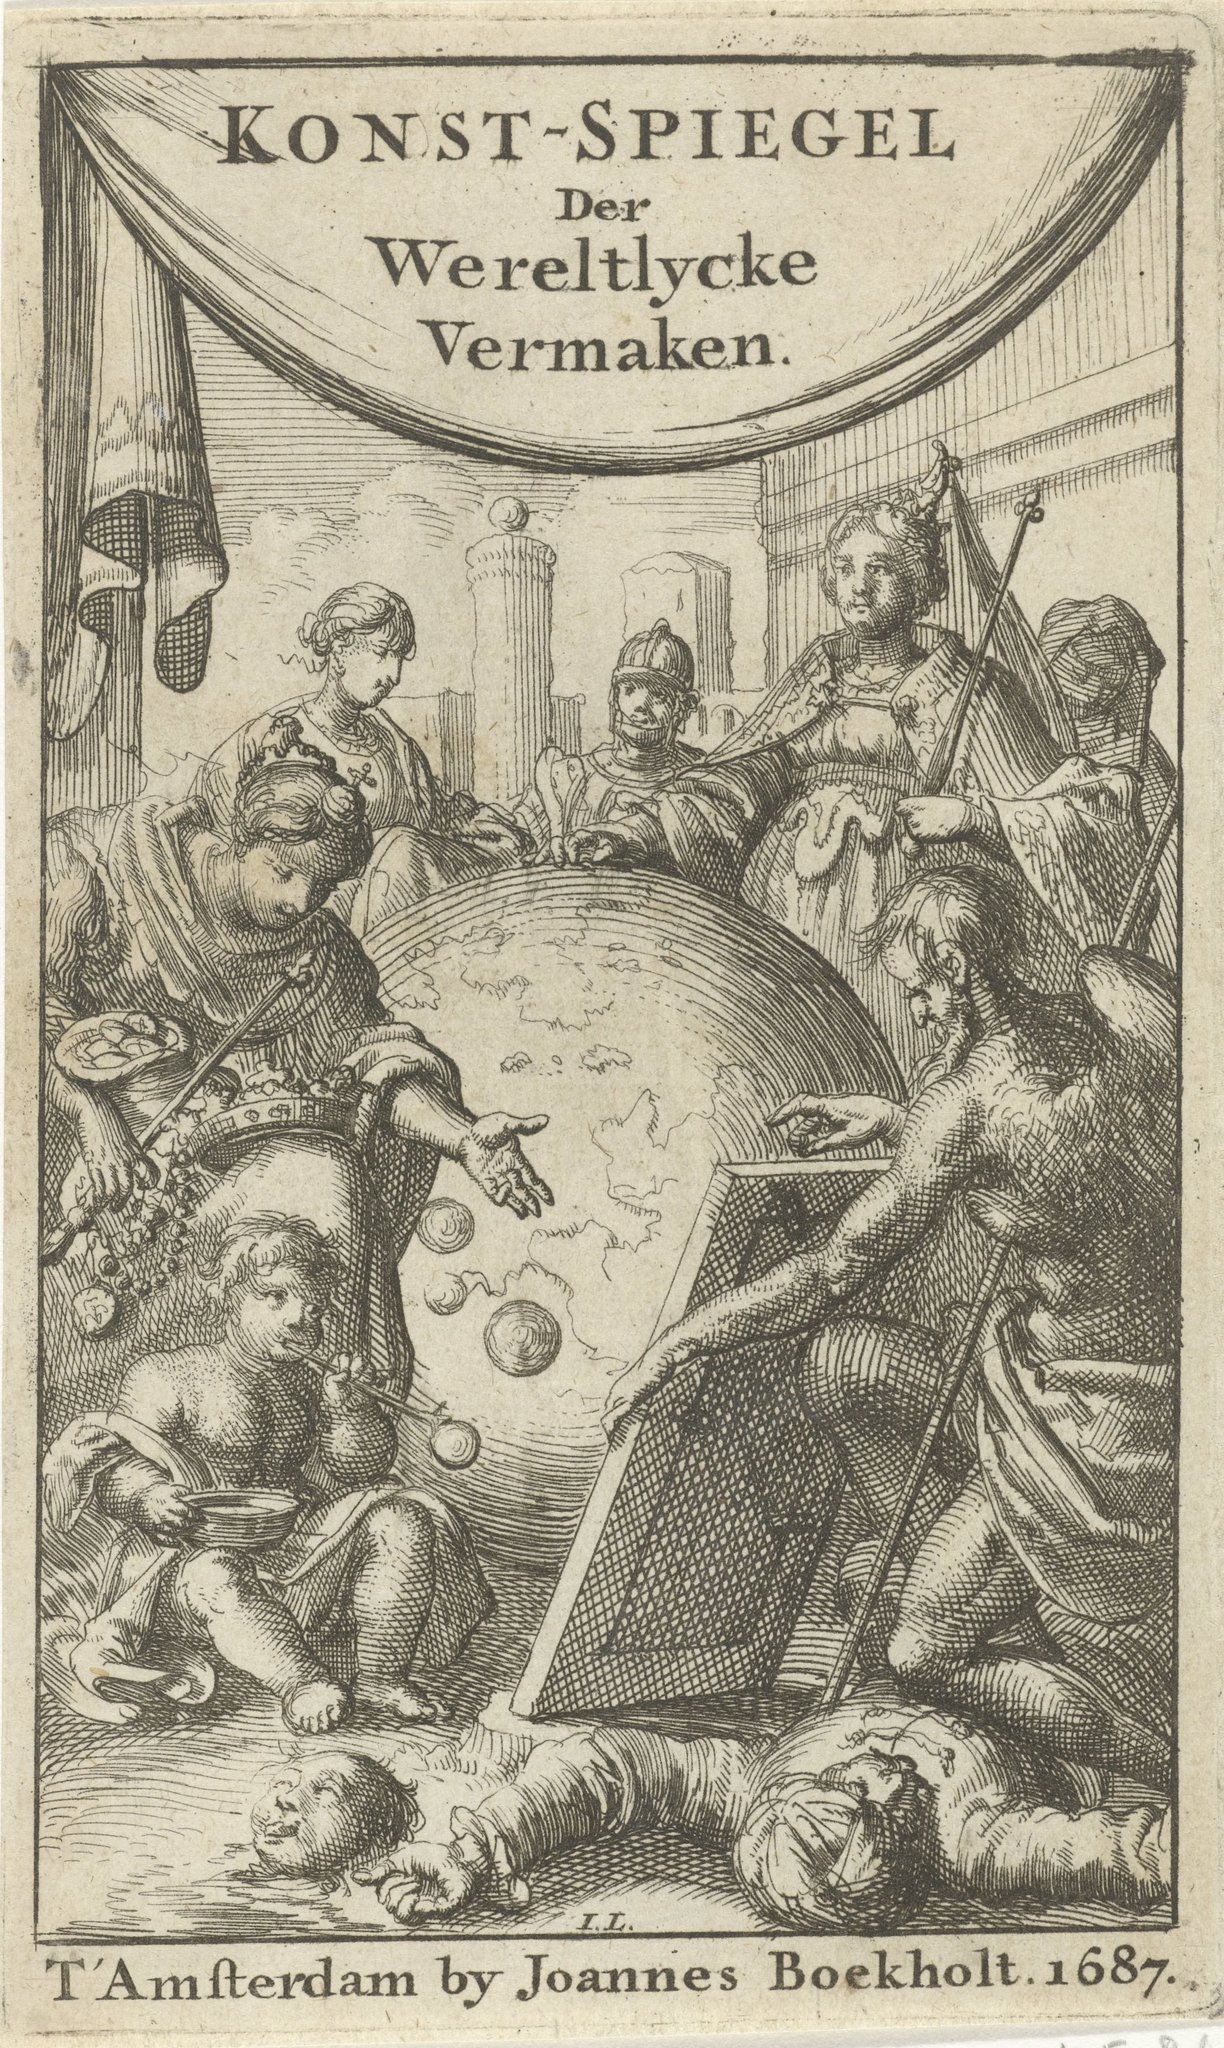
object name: titelblad, titelpagina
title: Vader Tijd houdt Vrouw Wereld een spiegel voor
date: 1687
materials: paper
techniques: etching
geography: amsterdam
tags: 'vanitas' symbols, father time, man with wings and scythe, 'frau welt'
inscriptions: collector's mark: Lugt 2228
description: Titelpagina voor: Ziegler, Georg. Konst-spiegel der weereltlikke vermaken. Amsterdam: Johannes Boekholt, 1687.